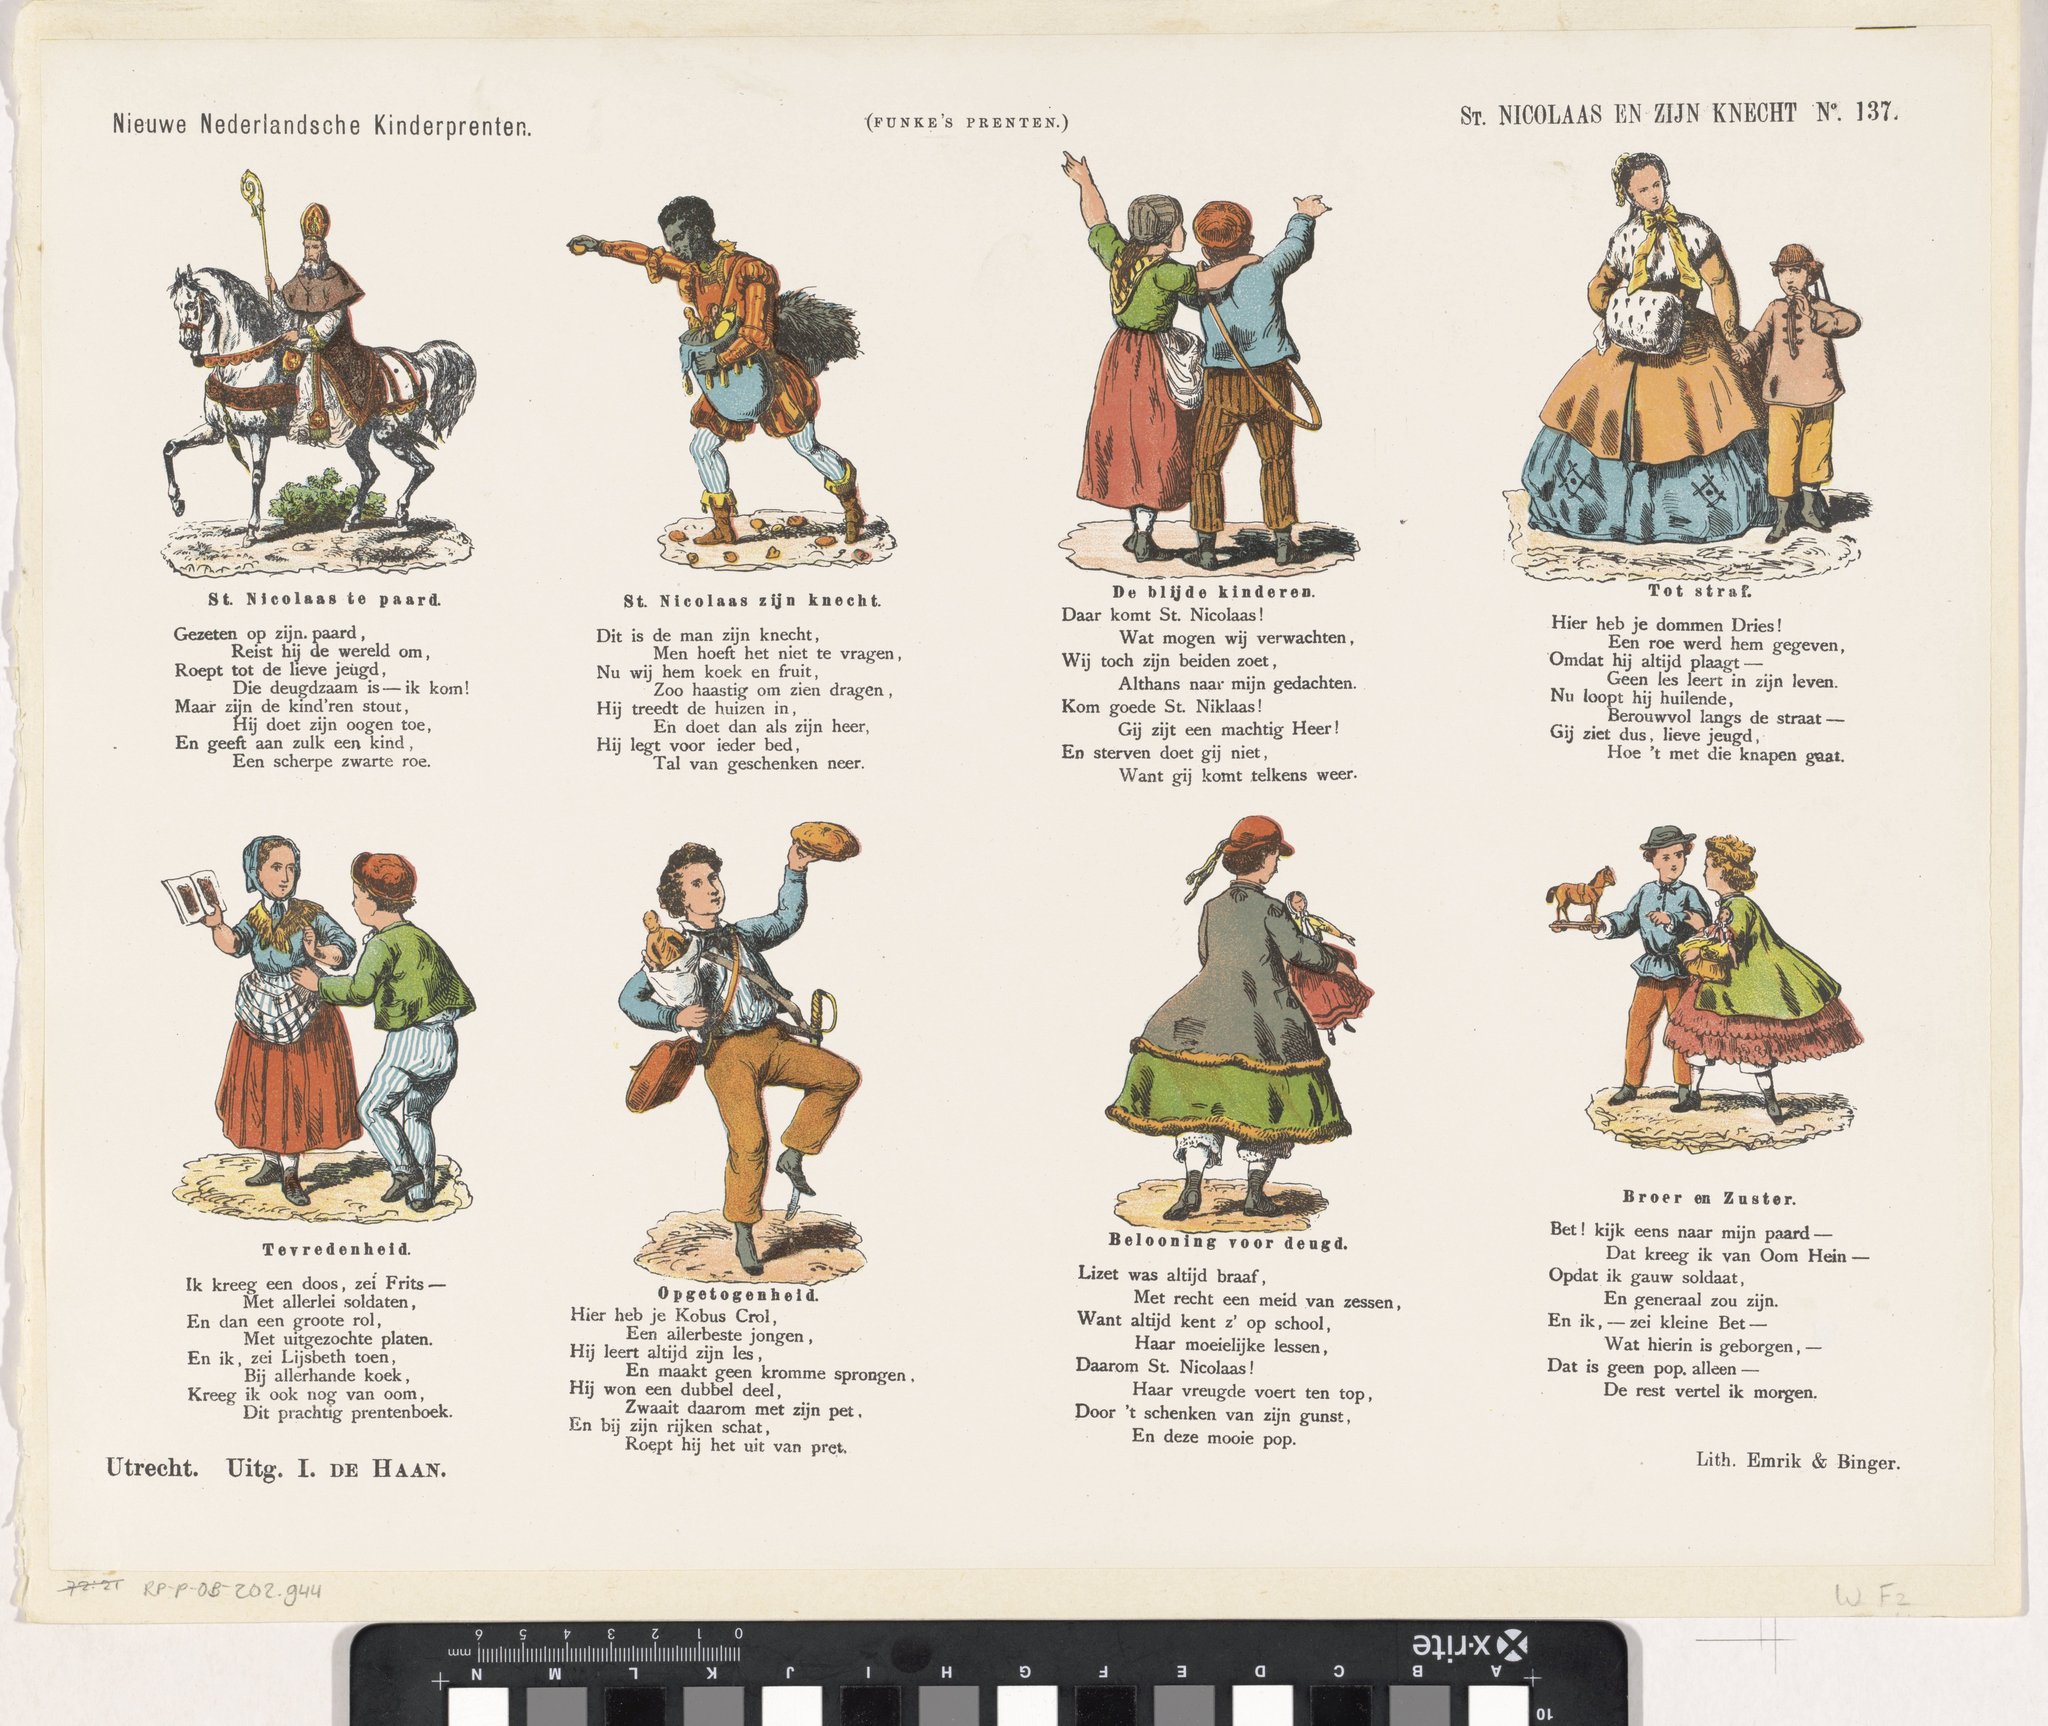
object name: print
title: Nieuwe Nederlandsche kinderprenten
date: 1875-1903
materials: paper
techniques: lithograph, letterpress printing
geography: haarlem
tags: the bishop nicholas of myra (or bari); possible attributes: anchor, boat, three golden balls (on a book), three purses, three children in a tub, three maidens, child, festivities on st. nicholas (eve) (december 5)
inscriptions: collector's mark: Lugt 2760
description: Blad met 8 voorstellingen van Sint Nicolaas, zwartepiet en kinderen. Onder elke afbeelding een titel en een vers. Genummerd rechtsboven: No. 137.